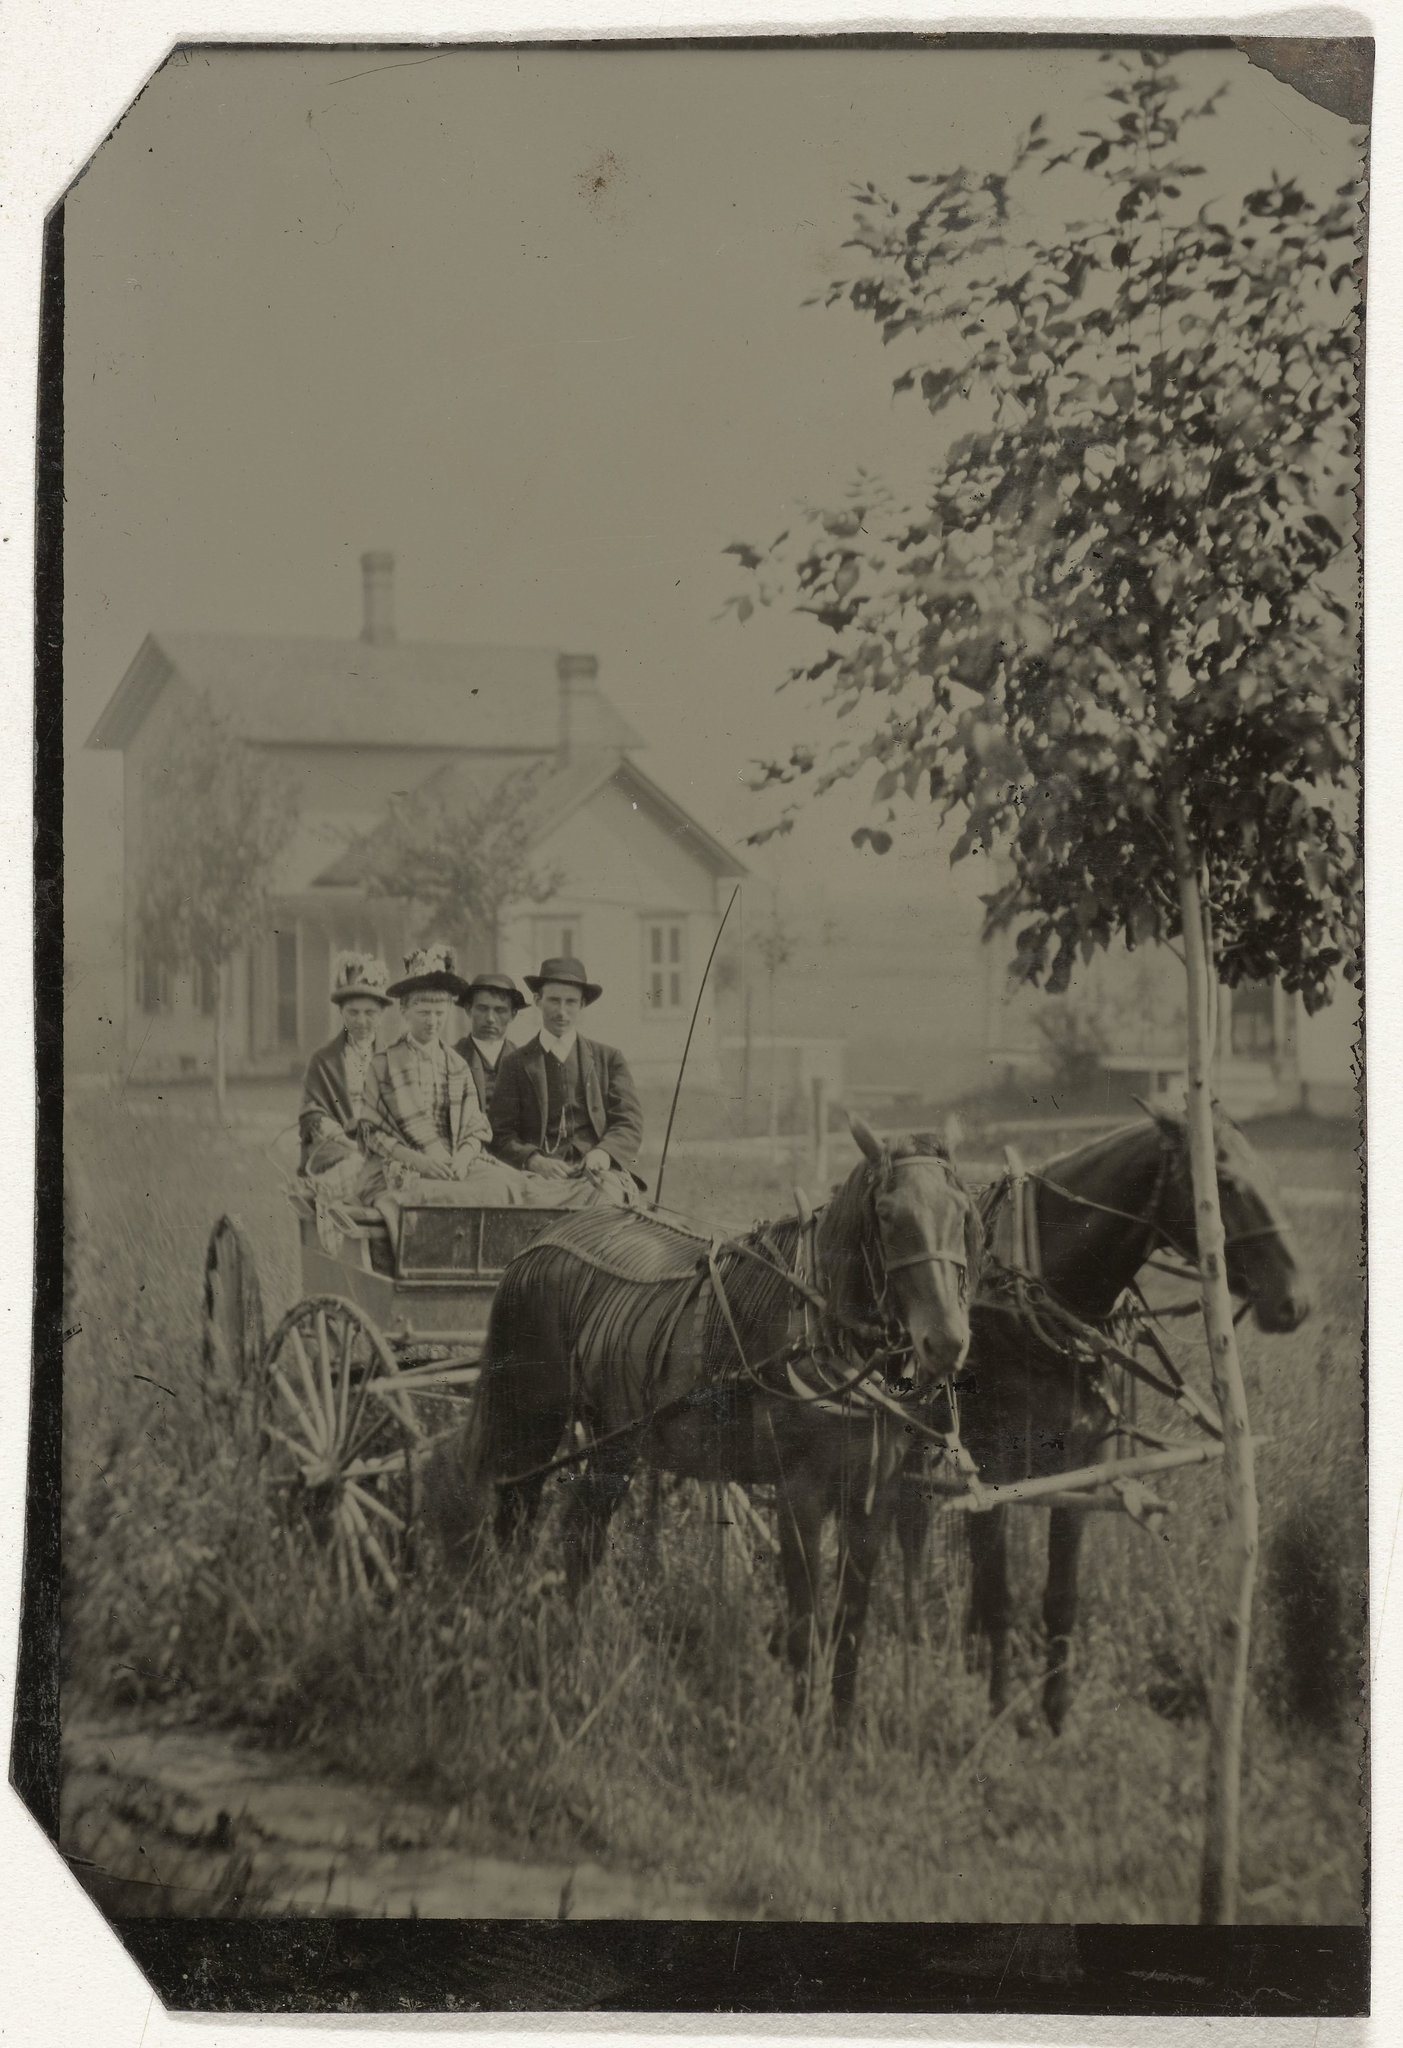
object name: photograph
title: Twee mannen en twee vrouwen in een koets met twee paarden ervoor, met op de achtergrond een houten huis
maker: Anonymous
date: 1870-1900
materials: metal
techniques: ferrotyping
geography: united states